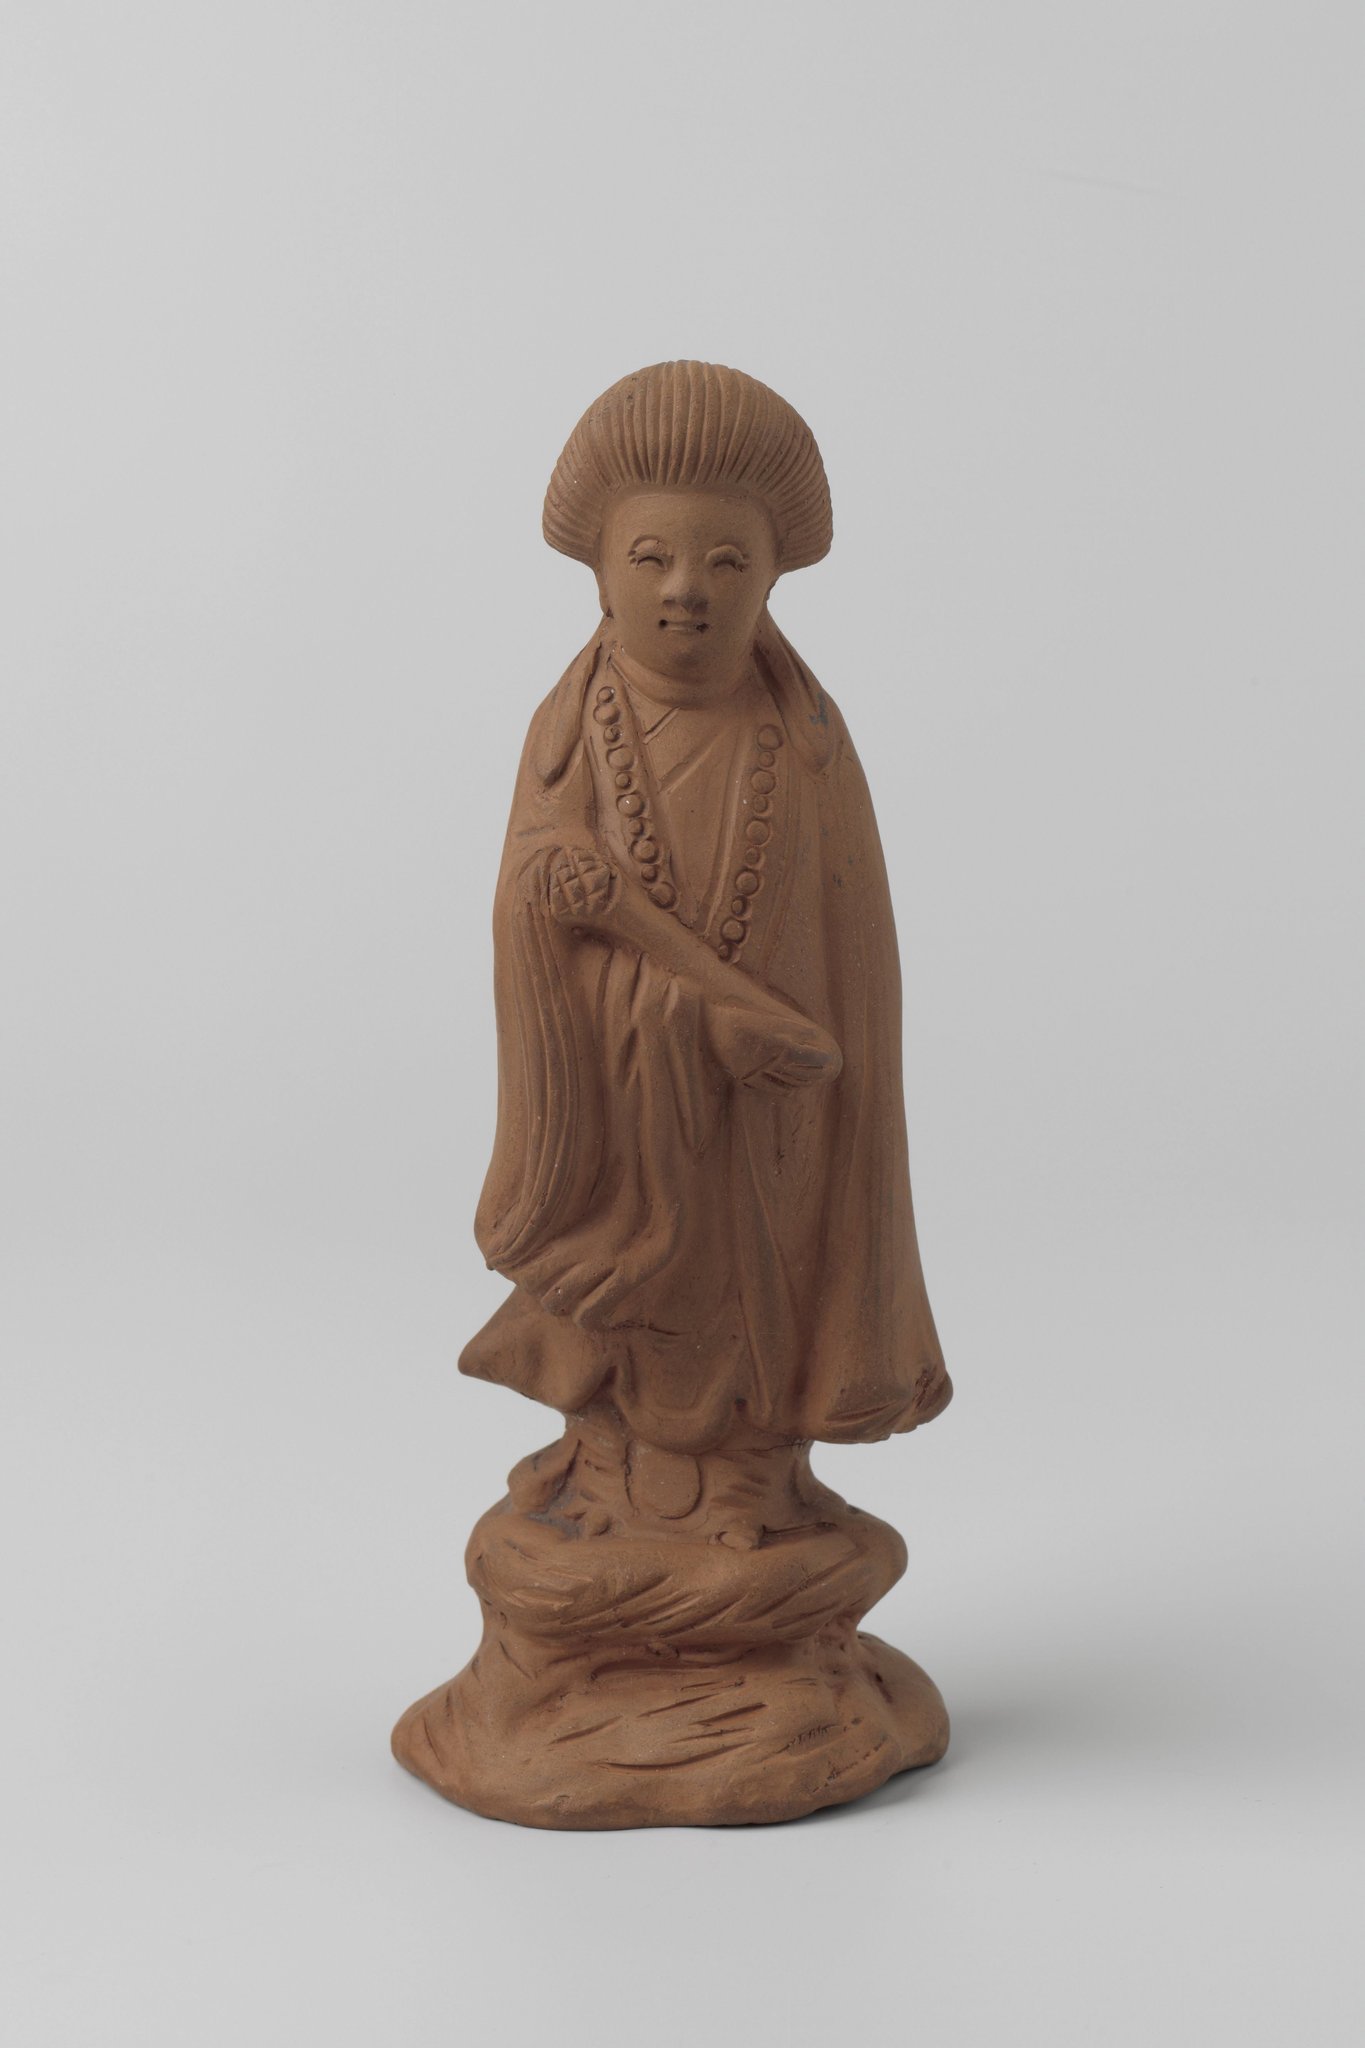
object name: vrouwenfiguur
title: Quan Yin van rood steengoed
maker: Anonymous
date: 1680-1720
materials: redware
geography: delft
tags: guan yin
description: Beeld van een staande vrouw met los neerhangend kleed met lange mouwen, staat op een rotsachtig voetstuk en houdt in haar rechterhand een vliegenkwaet. Achter op haar kapsel is een doekje gedrapeerd, waarvan de slippen over de schouders vallen.